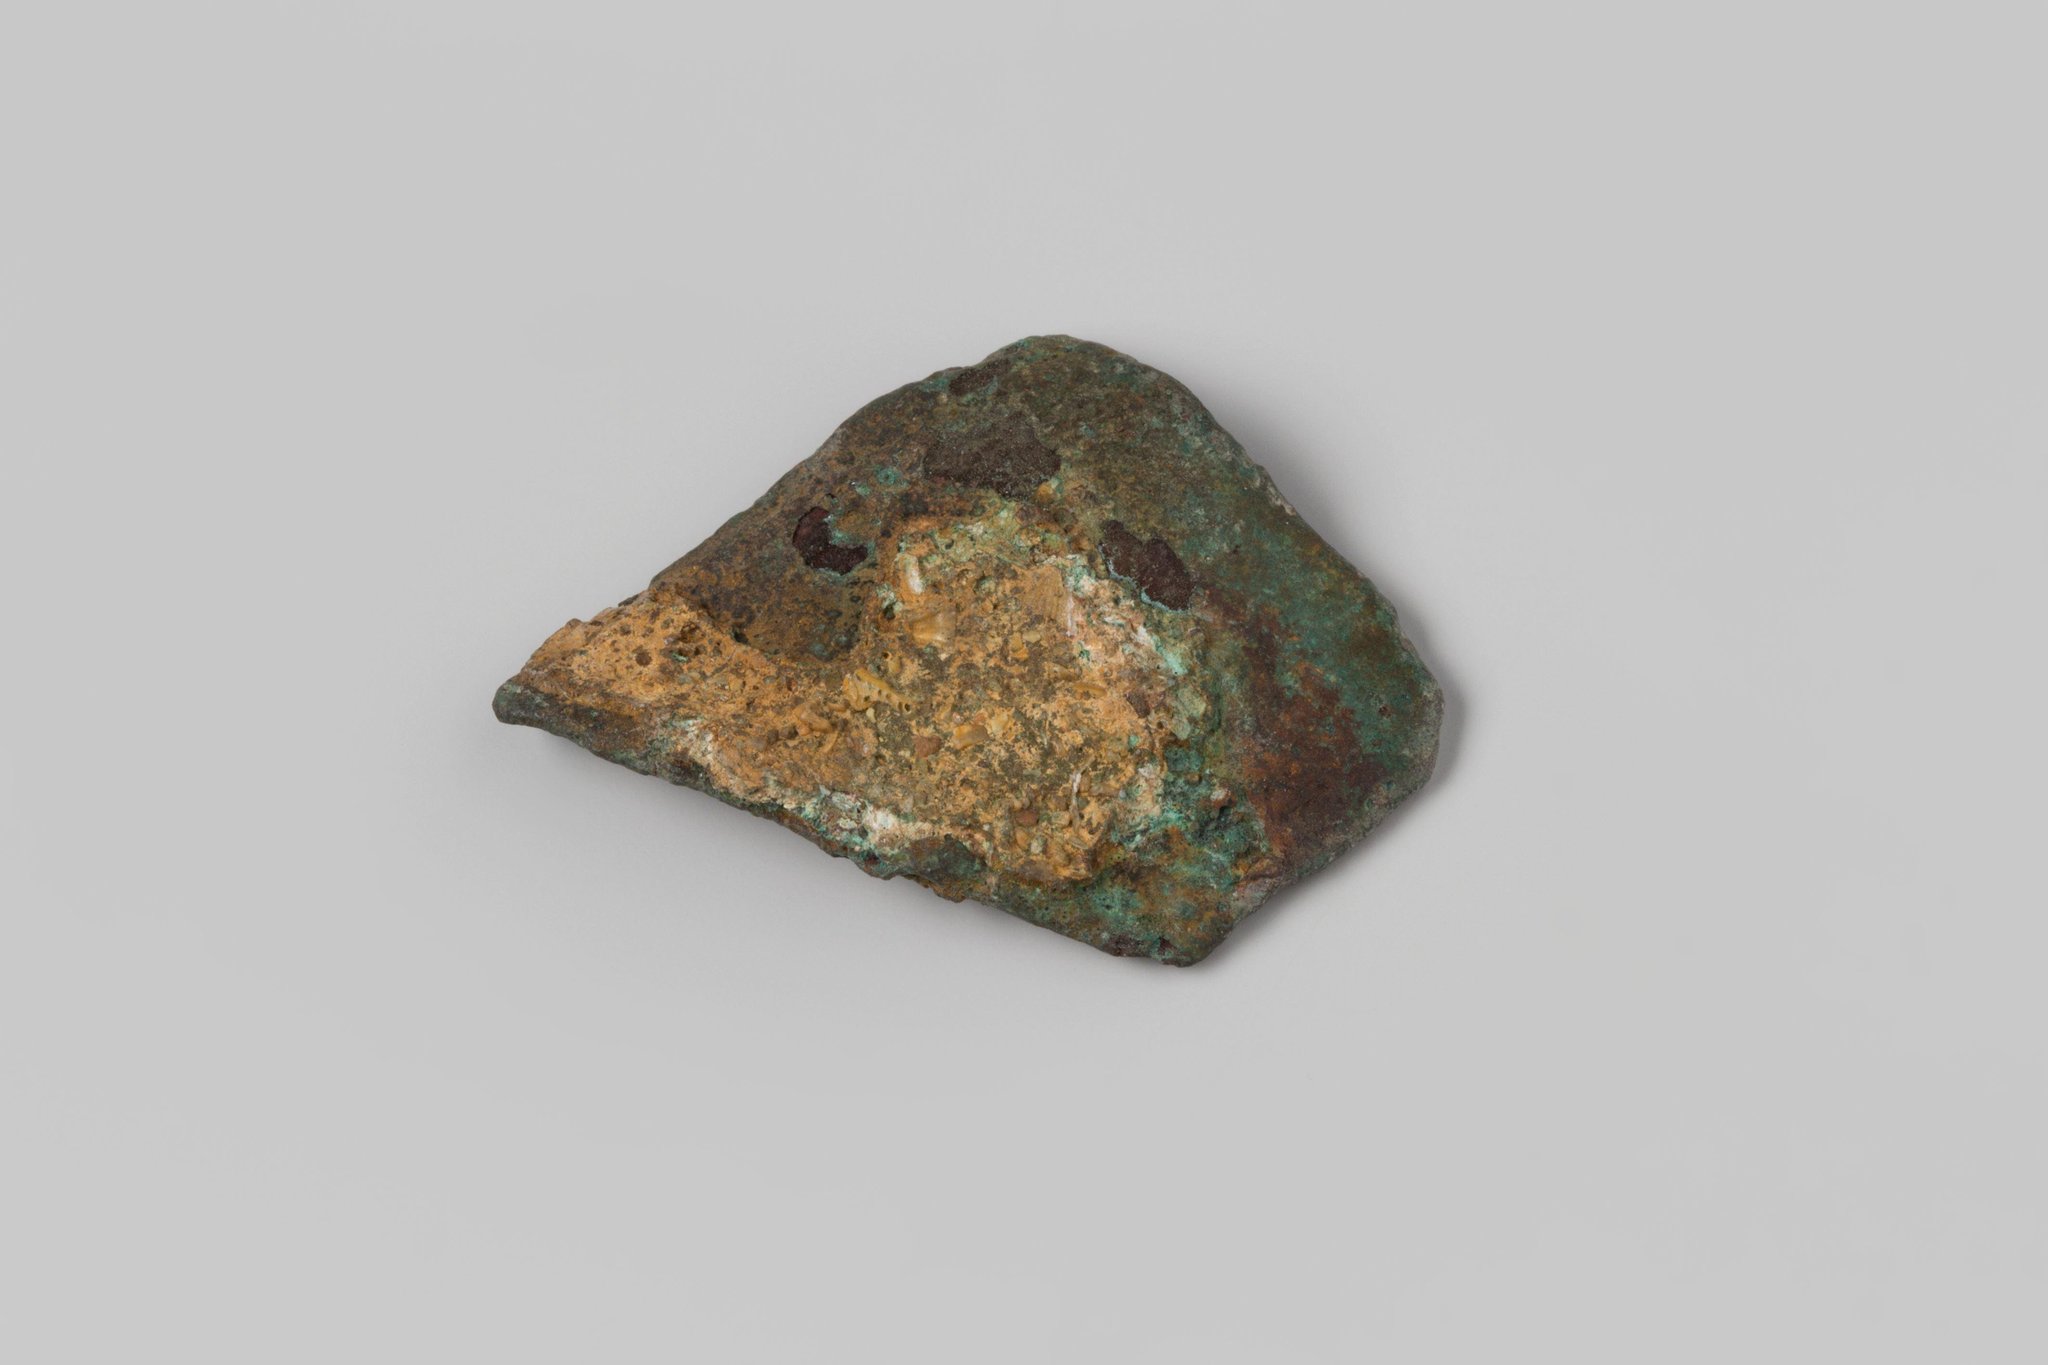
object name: scheepswrakvondst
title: Fragment van koper uit het wrak van de Oost-Indiëvaarder Hollandia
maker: Anonymous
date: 1700-1743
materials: copper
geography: netherlands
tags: verenigde oostindische compagnie, hollandia (schip), annet